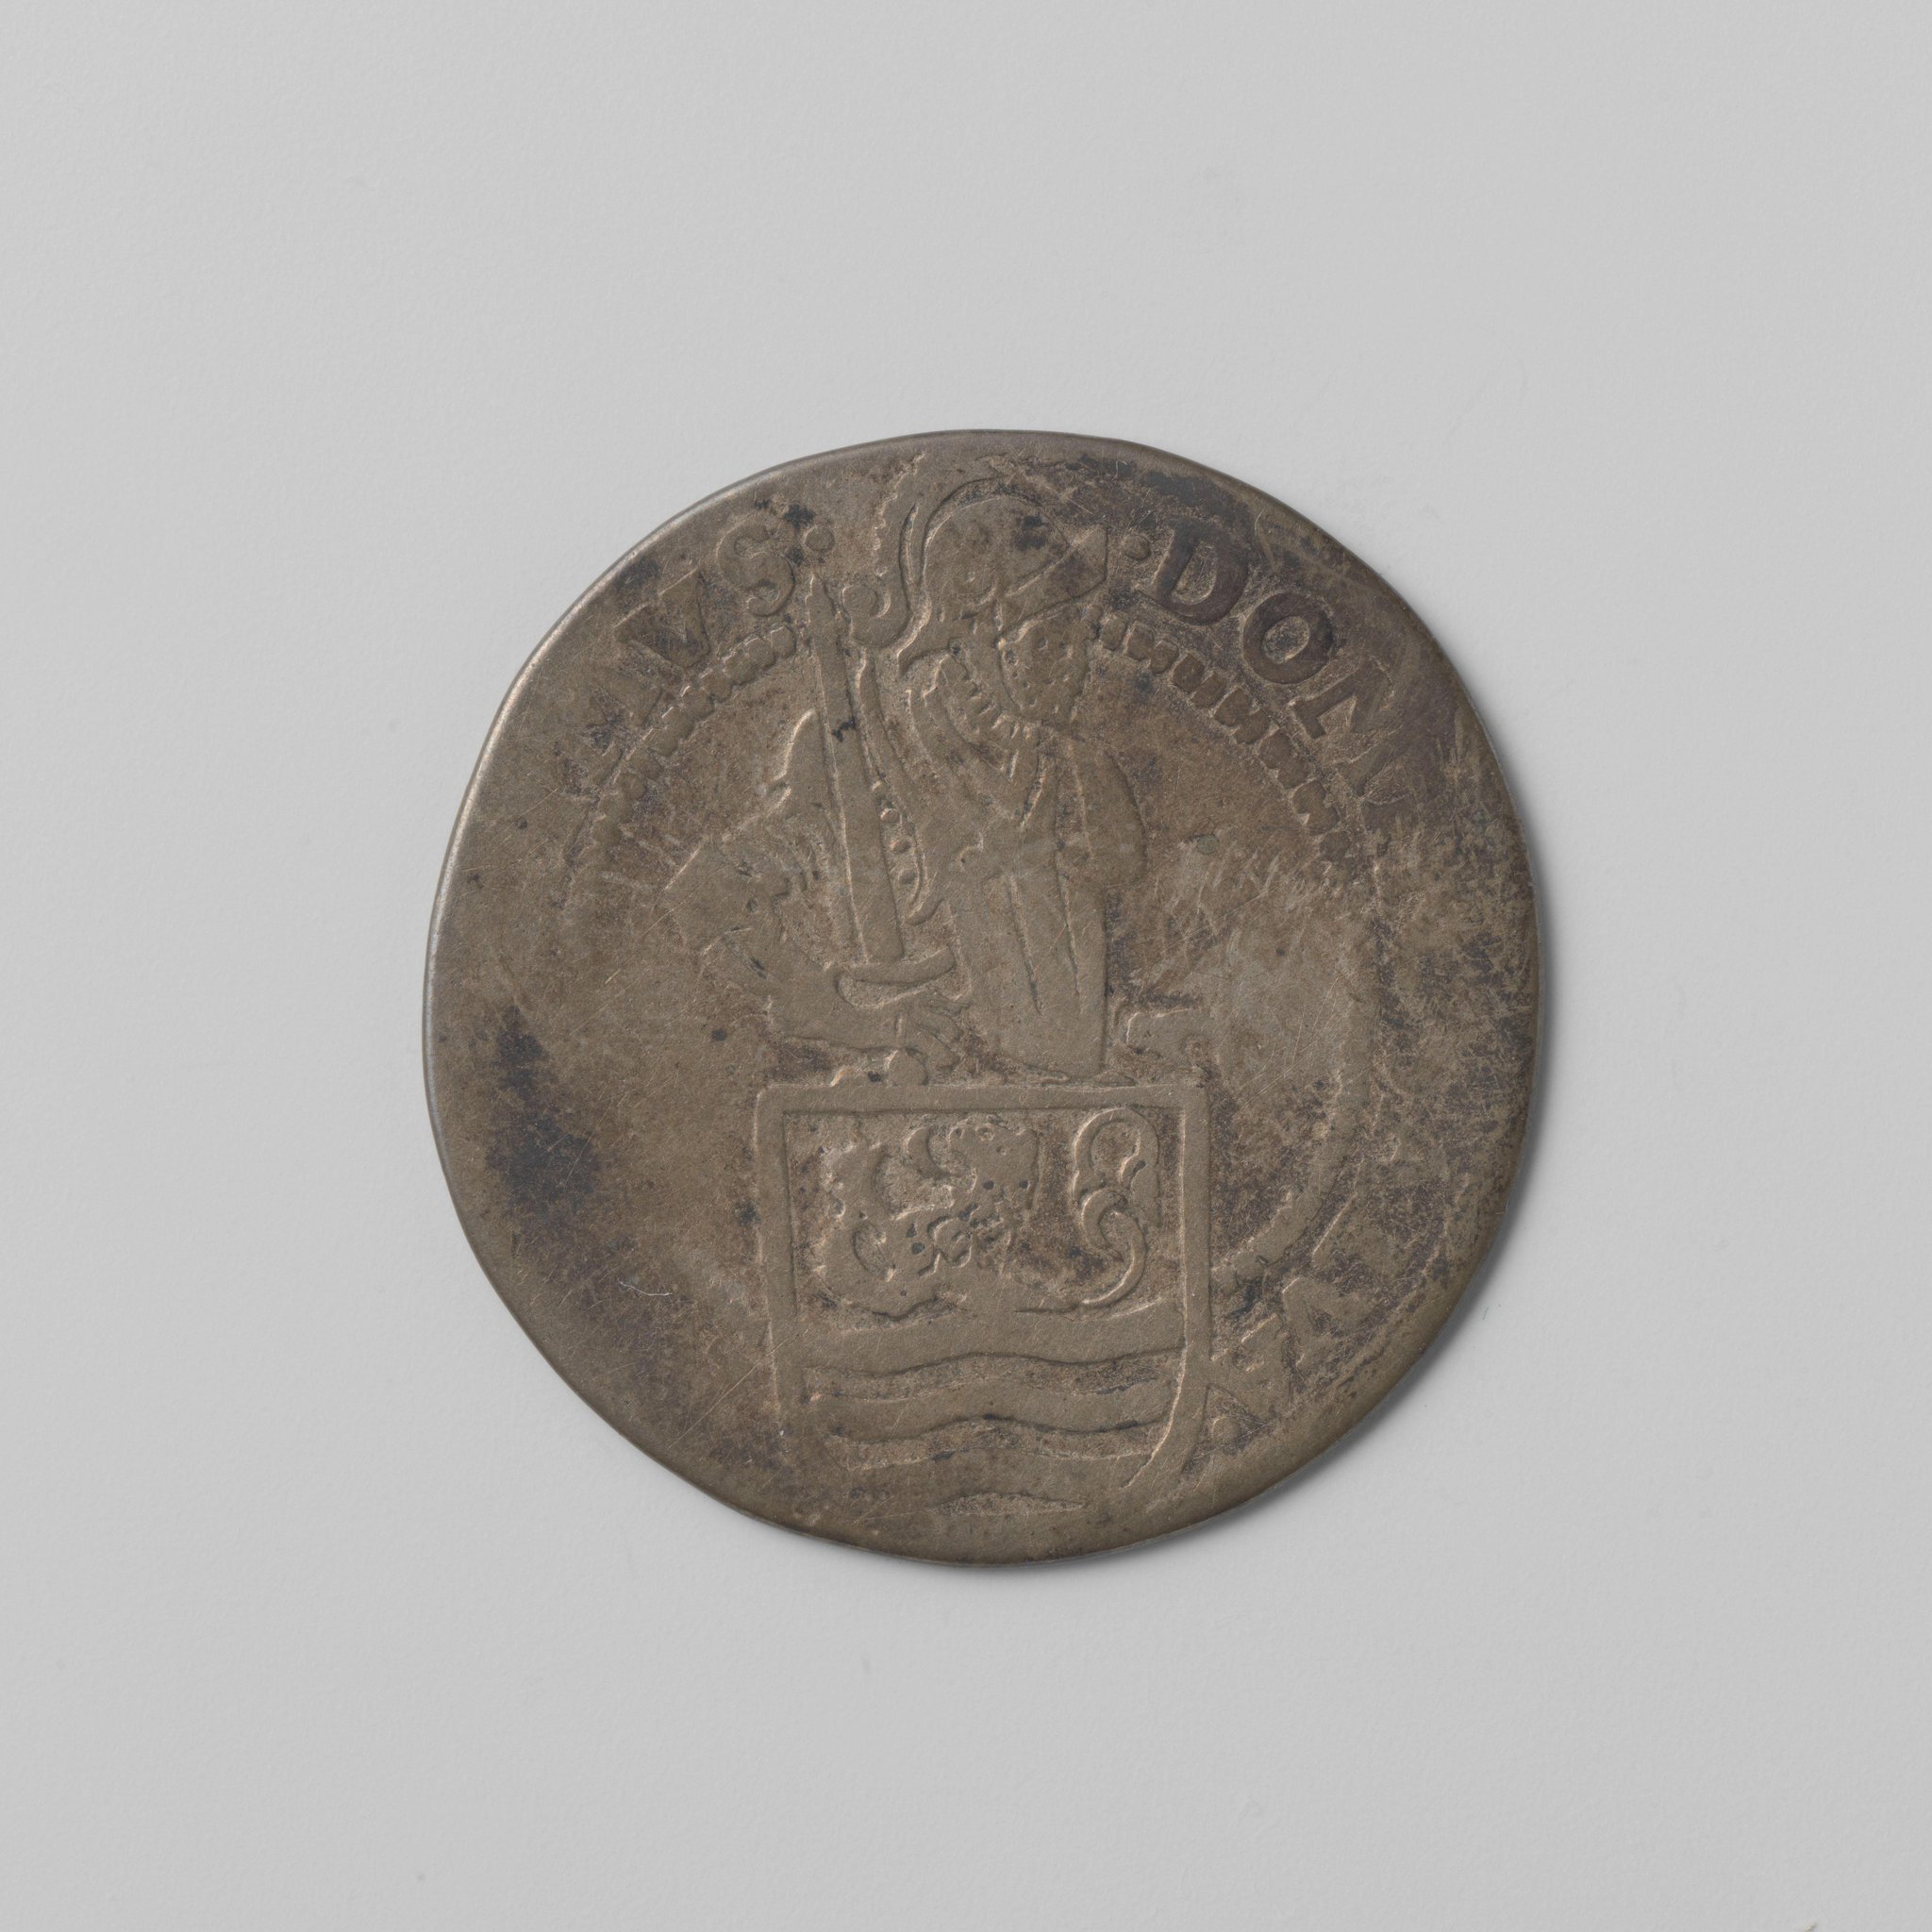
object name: coin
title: Zeeuwse snaphaanschelling, 1583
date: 1583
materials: silver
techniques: striking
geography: middelburg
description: Zilveren munt. Voorzijde: staande geharnaste ridder naar rechts met zwaard in rechterhand en wapenschild van Zeeland voor zich. Keerzijde: kort versierd kruis met in het hart wapenschild van Zeeland, verkort jaartal 83 aan eind van omschrift.